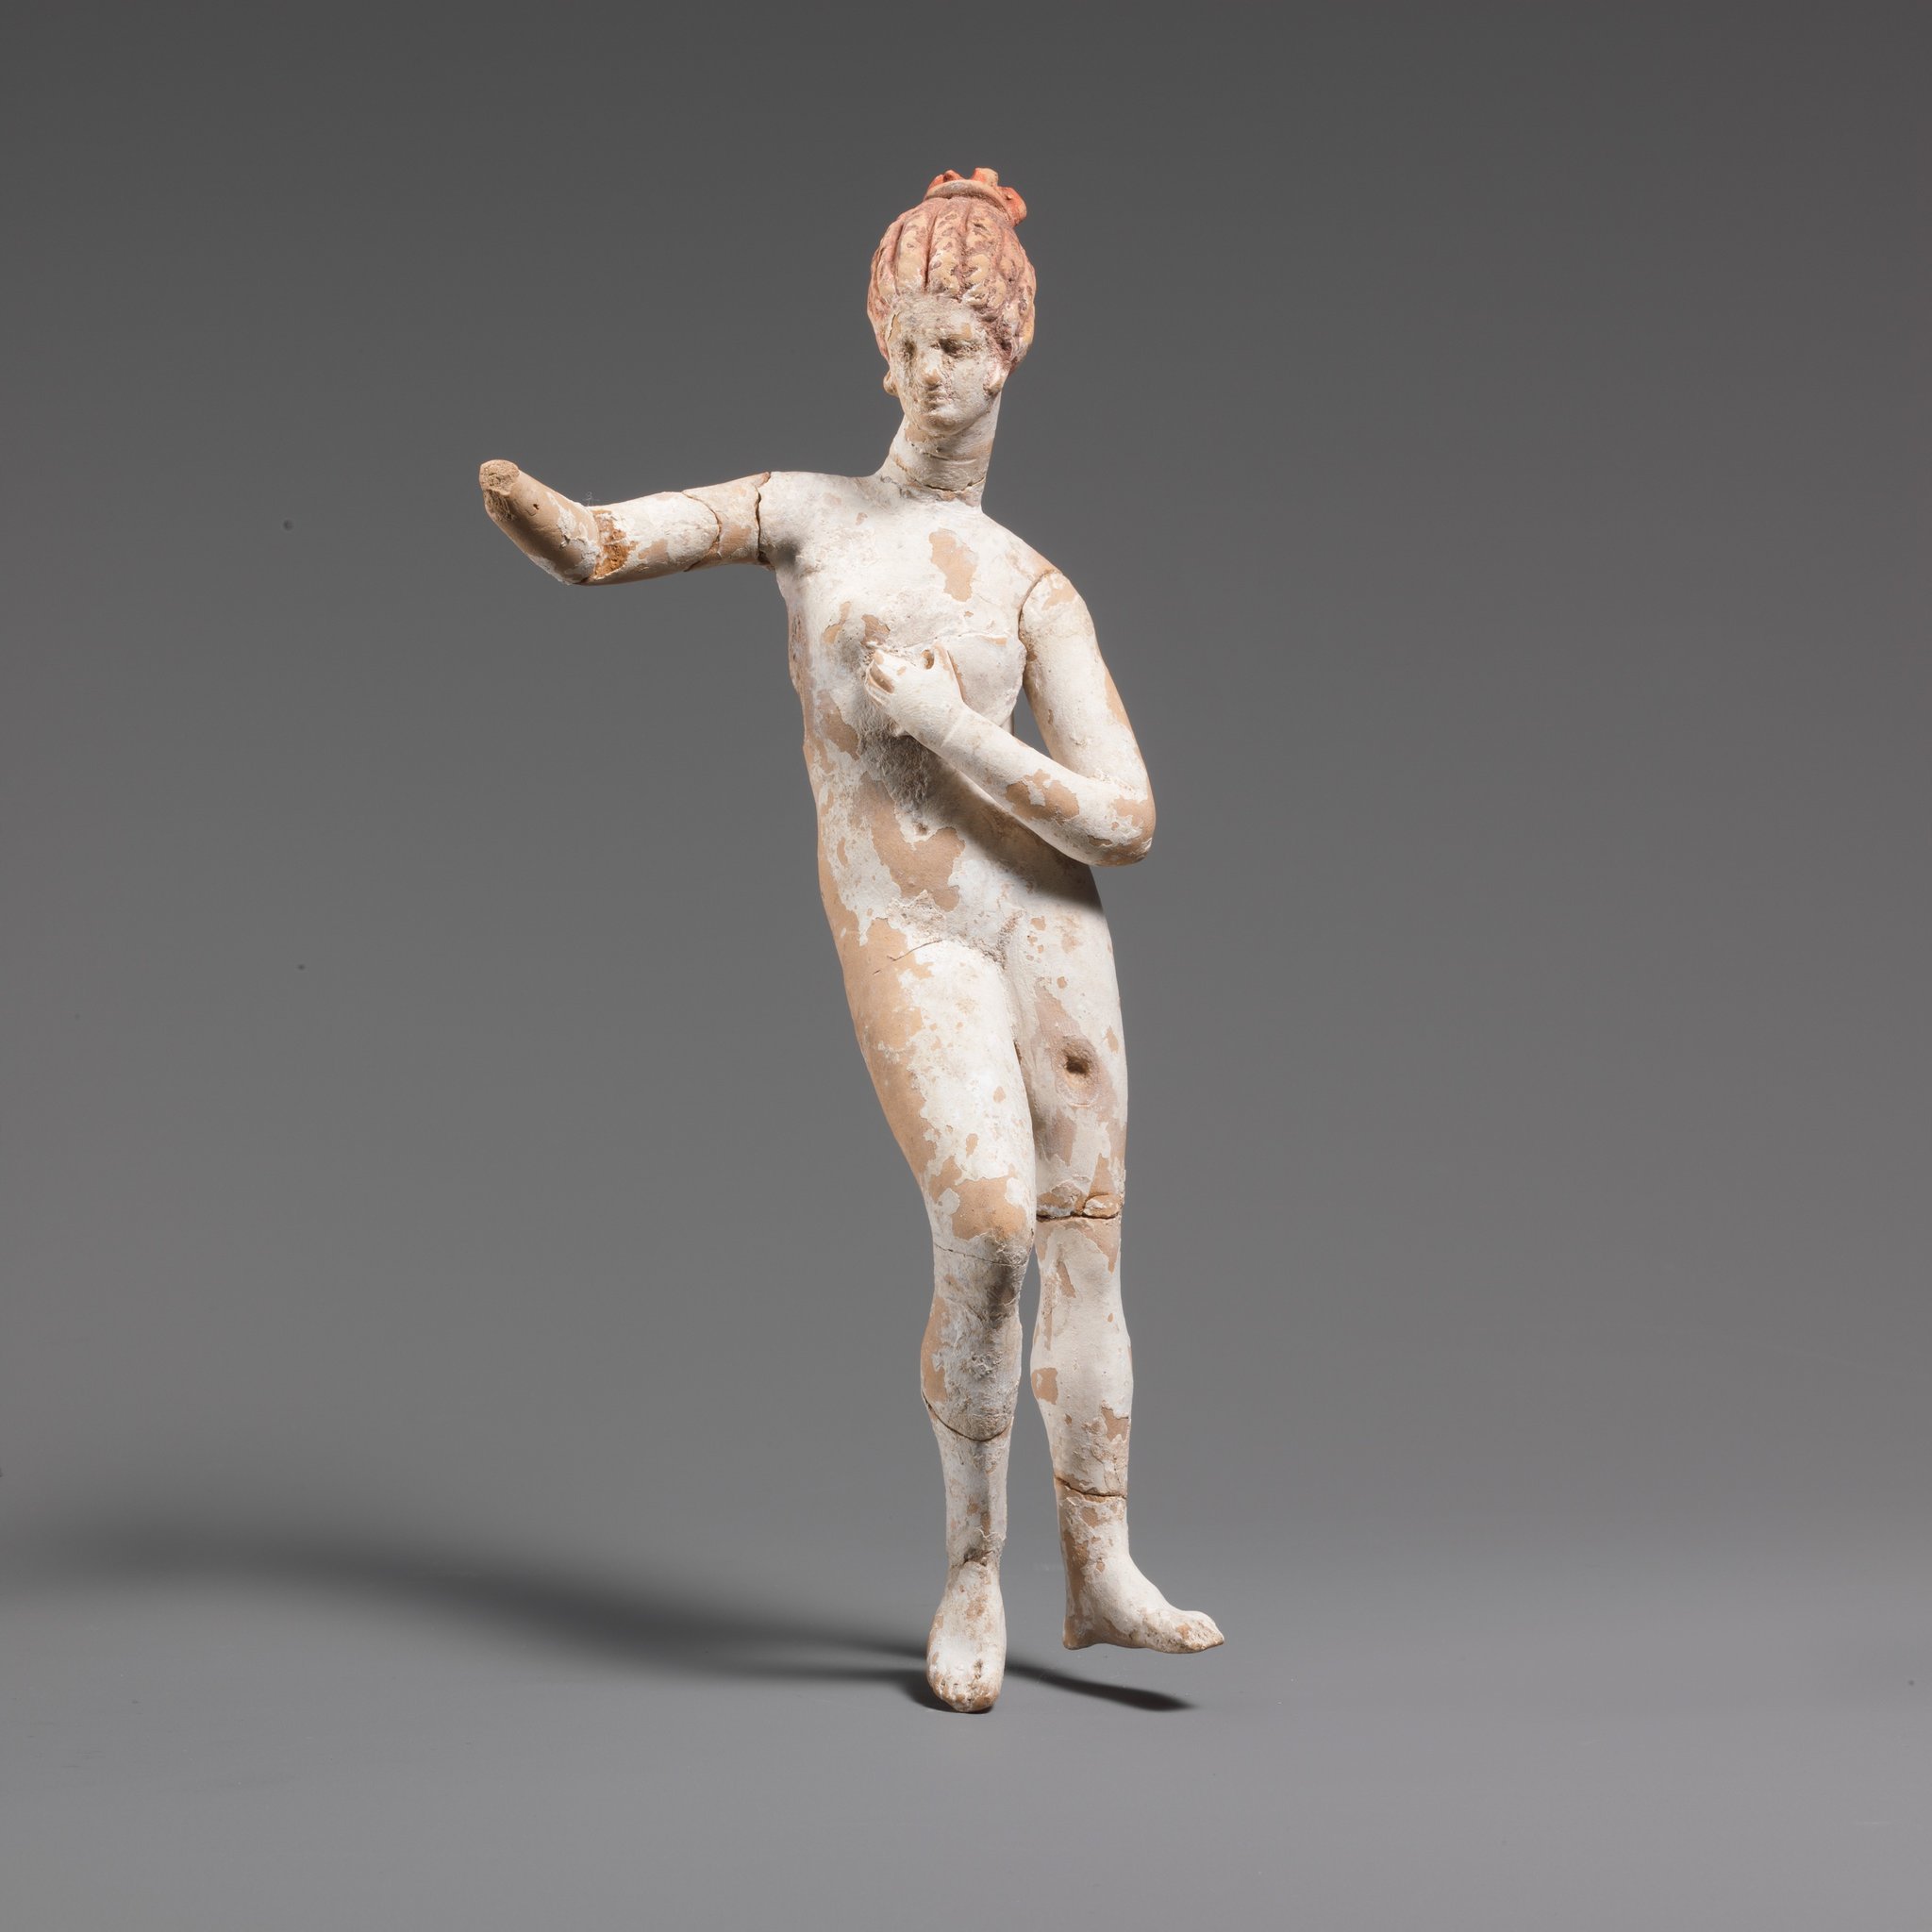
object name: statuette of a woman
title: Terracotta statuette of a nude woman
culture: greek, south italian, tarentine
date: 300-201 BCE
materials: terracotta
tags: female nudes,aphrodite